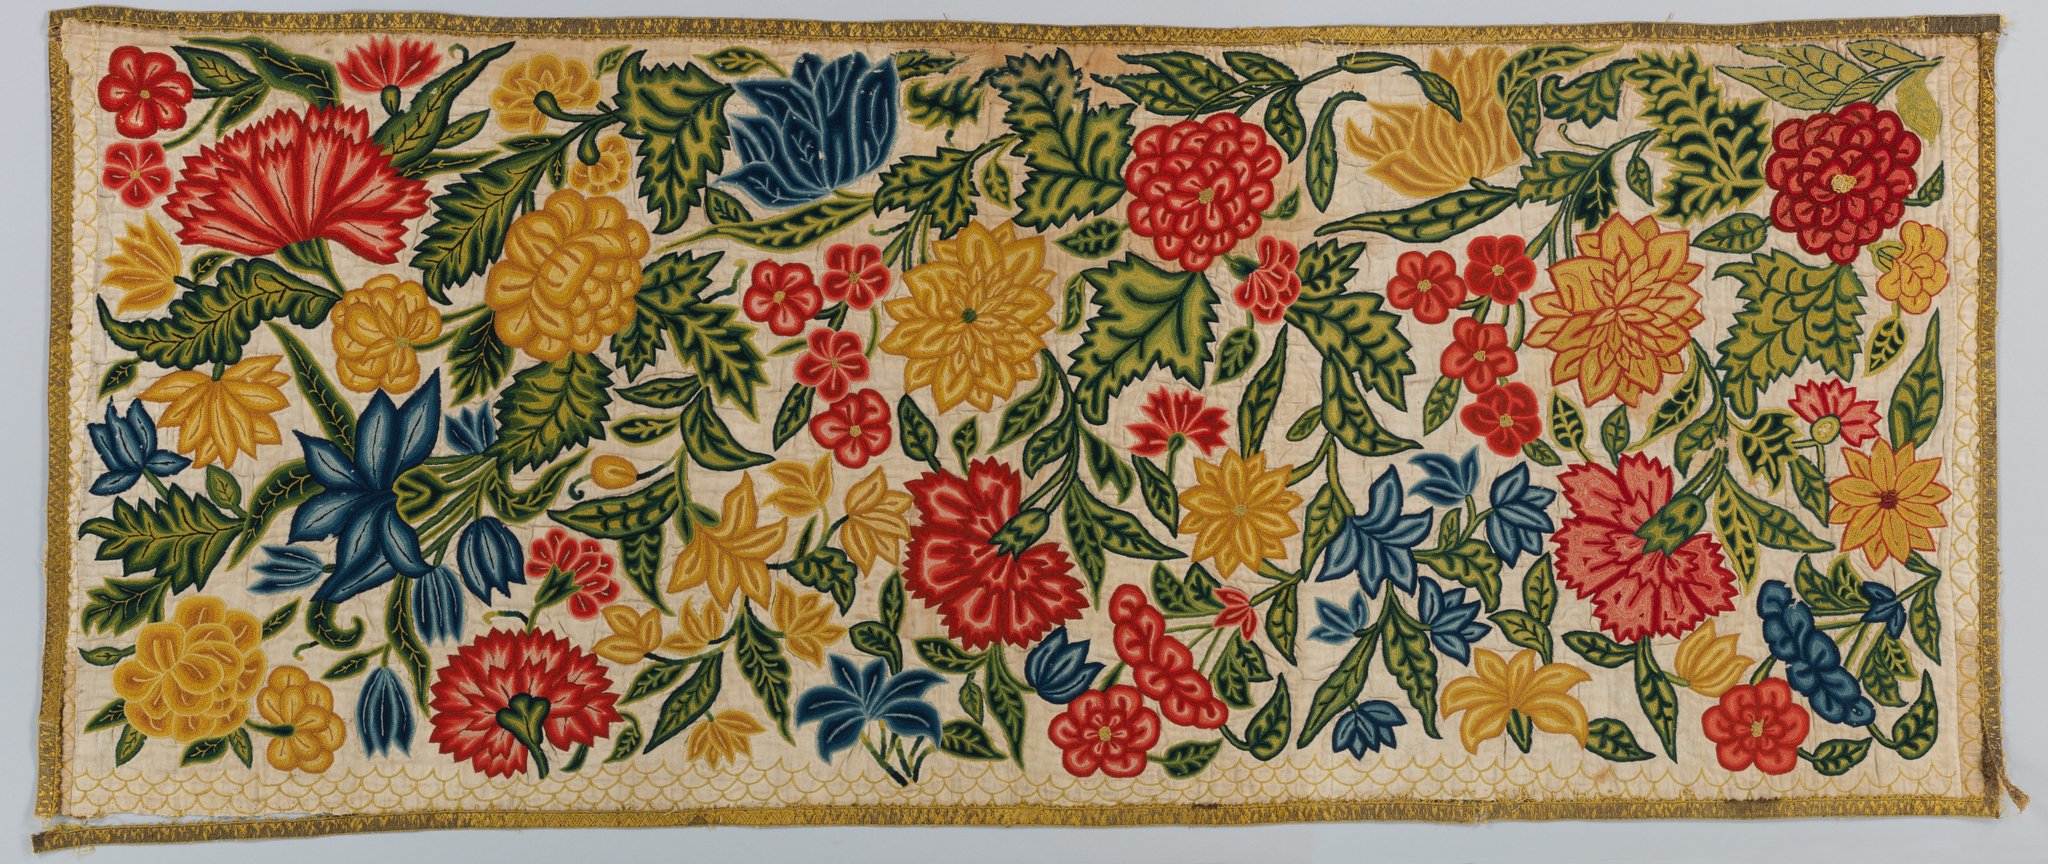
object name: panel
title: Panels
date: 1701-1725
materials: linen, silk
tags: flowers